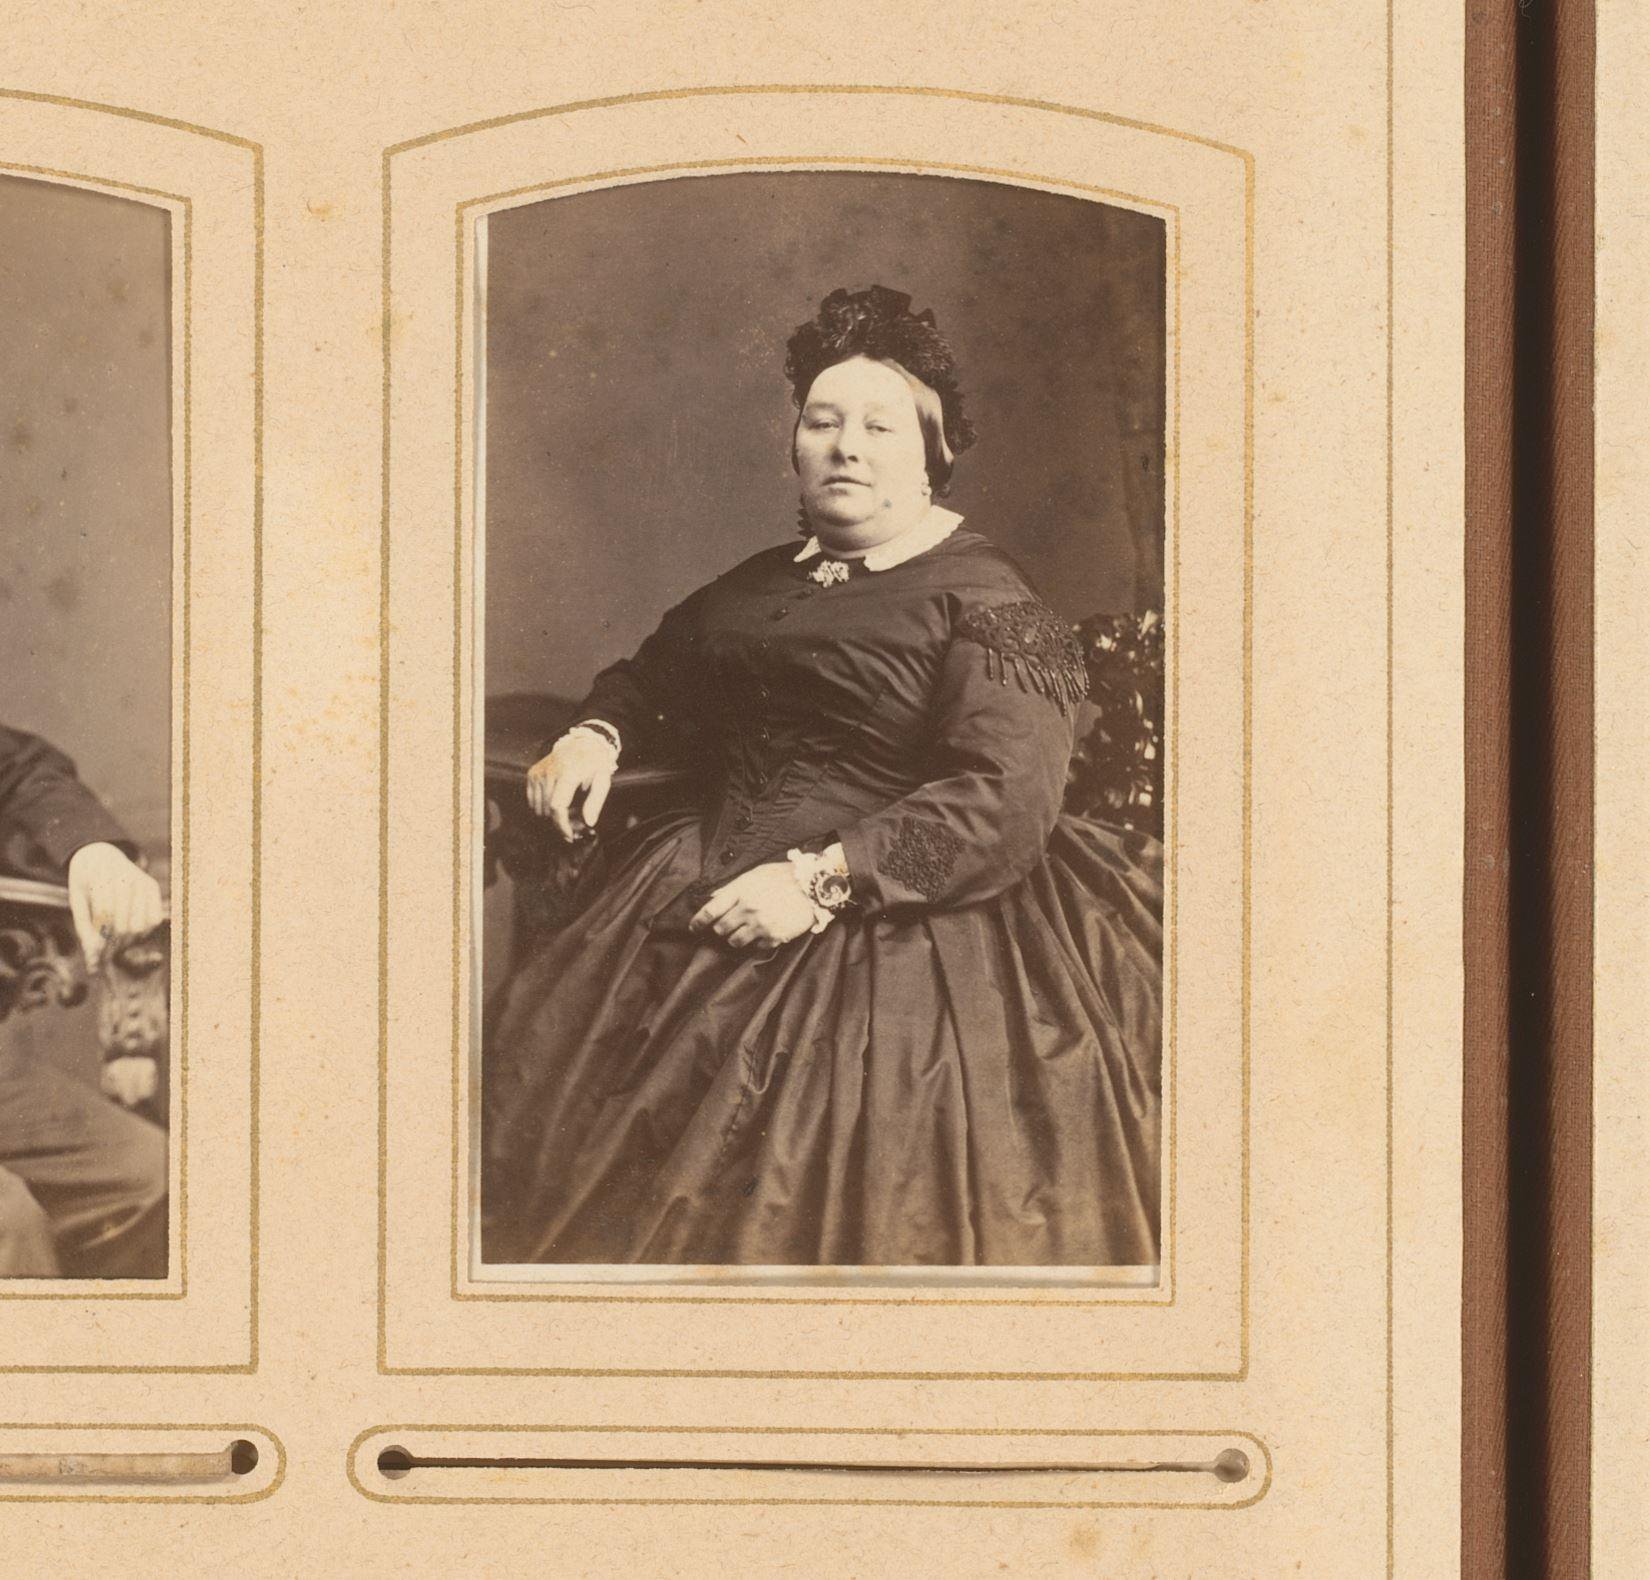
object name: photograph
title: Portret van een zittende vrouw met muts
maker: matthijs adolph conen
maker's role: painter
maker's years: 1833-1894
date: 1850-1894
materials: cardboard, photographic support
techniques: albumen print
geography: amsterdam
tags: sitting figure - aa - female human figure, historical persons - bb - woman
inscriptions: inscription: ‘ADOLPHE CONEN/ PEINTRE-PHOTOGRAPHE’